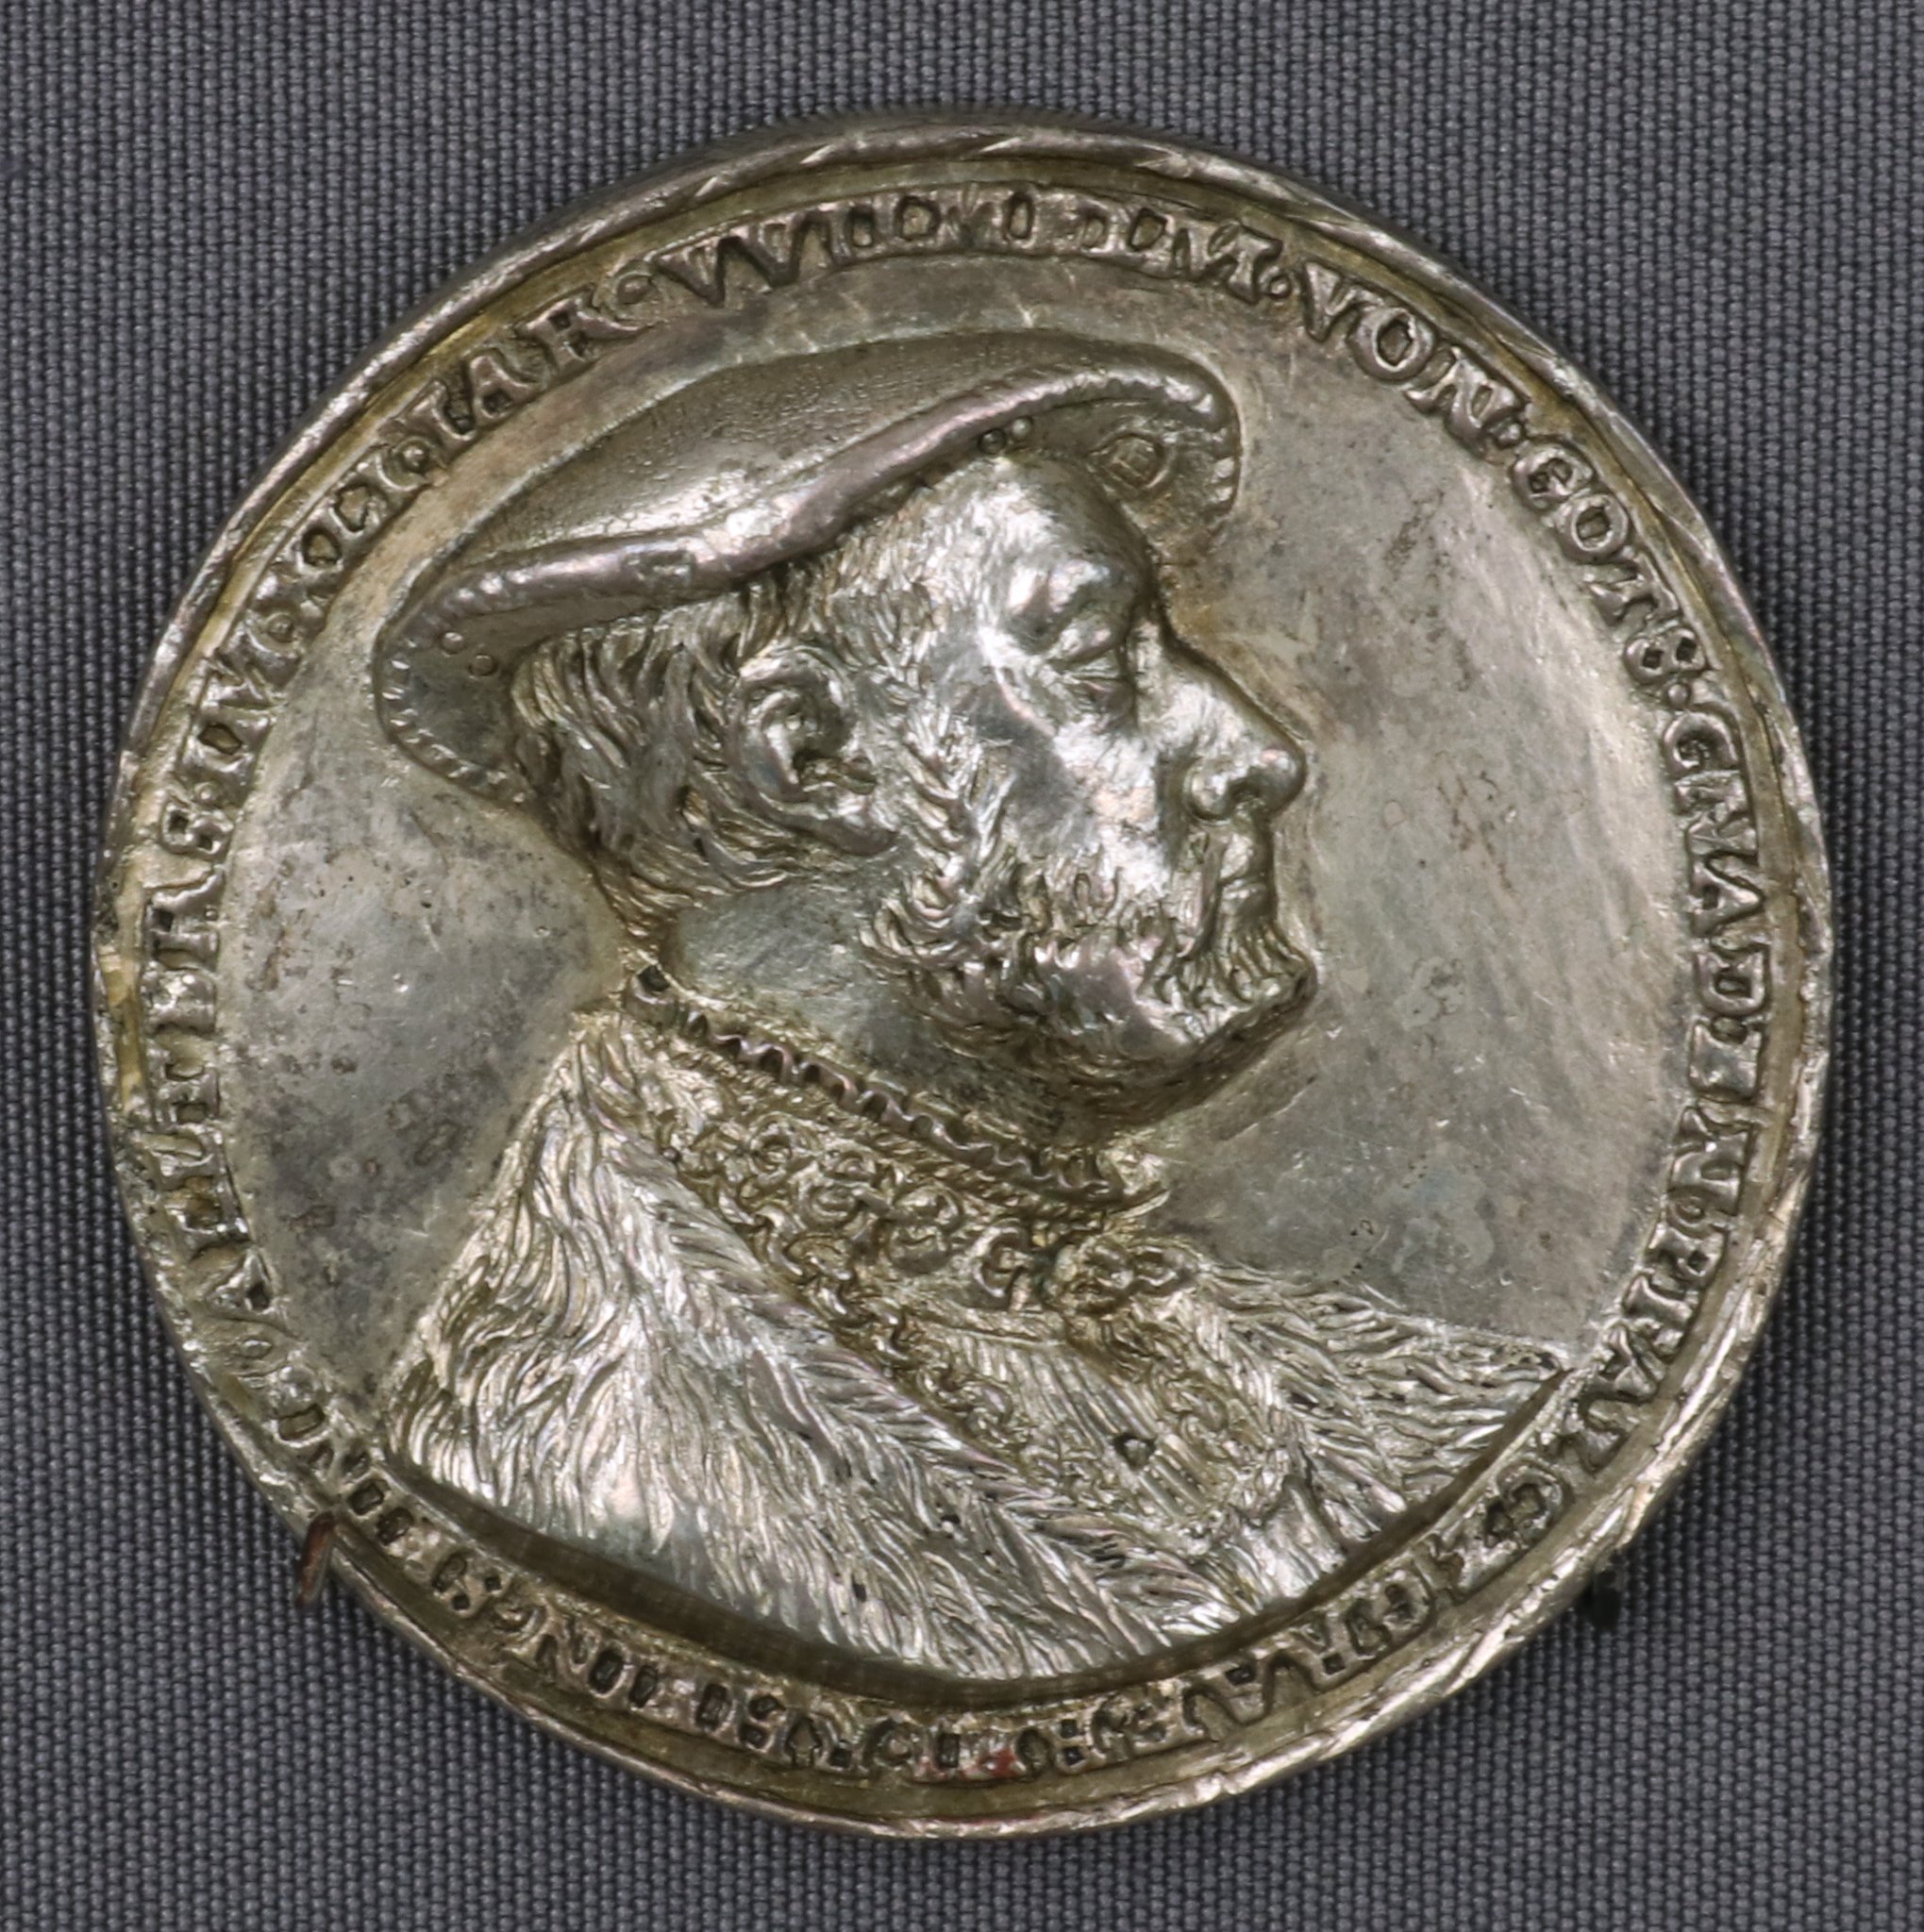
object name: medal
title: Wilhelm IV, Count Palatine, Duke of Bavaria (1493–1550)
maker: matthes gebel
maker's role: artist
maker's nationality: german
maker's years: 1523-1574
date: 1535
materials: silver